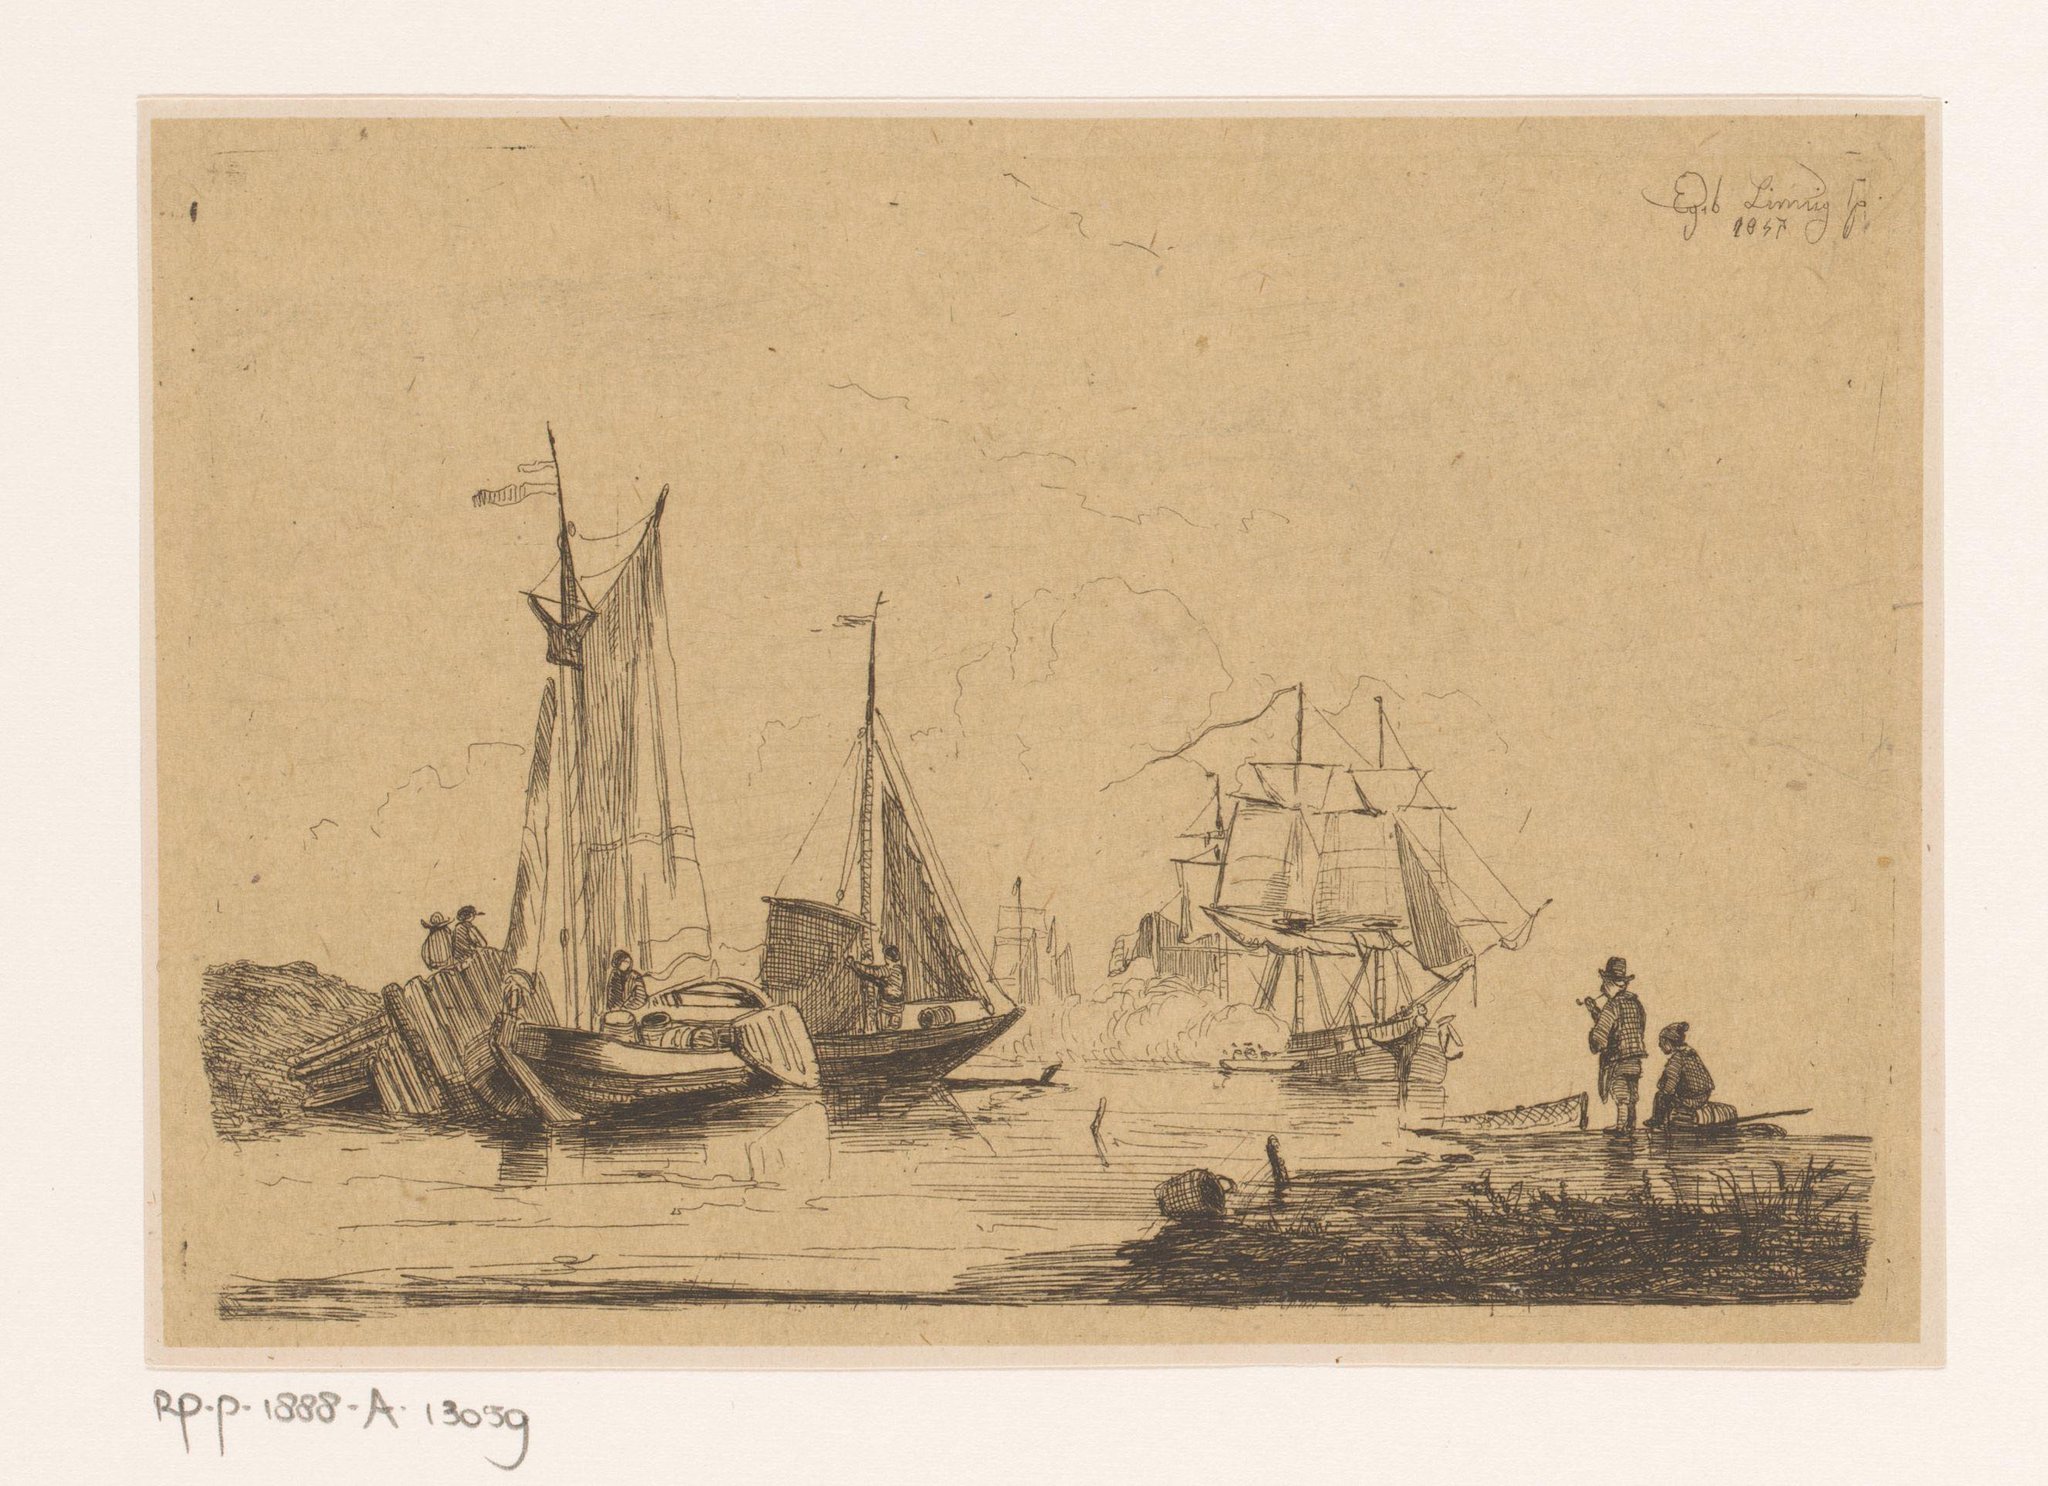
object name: print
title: Saluutschoten bij het uitzeilen van de driemaster Macassar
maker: egidius linnig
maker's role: draughtsman, print maker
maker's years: 1821-1860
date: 1847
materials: paper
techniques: etching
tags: sailing-ship, sailing-boat, firearms: cannon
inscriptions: collector's mark: Lugt 2228